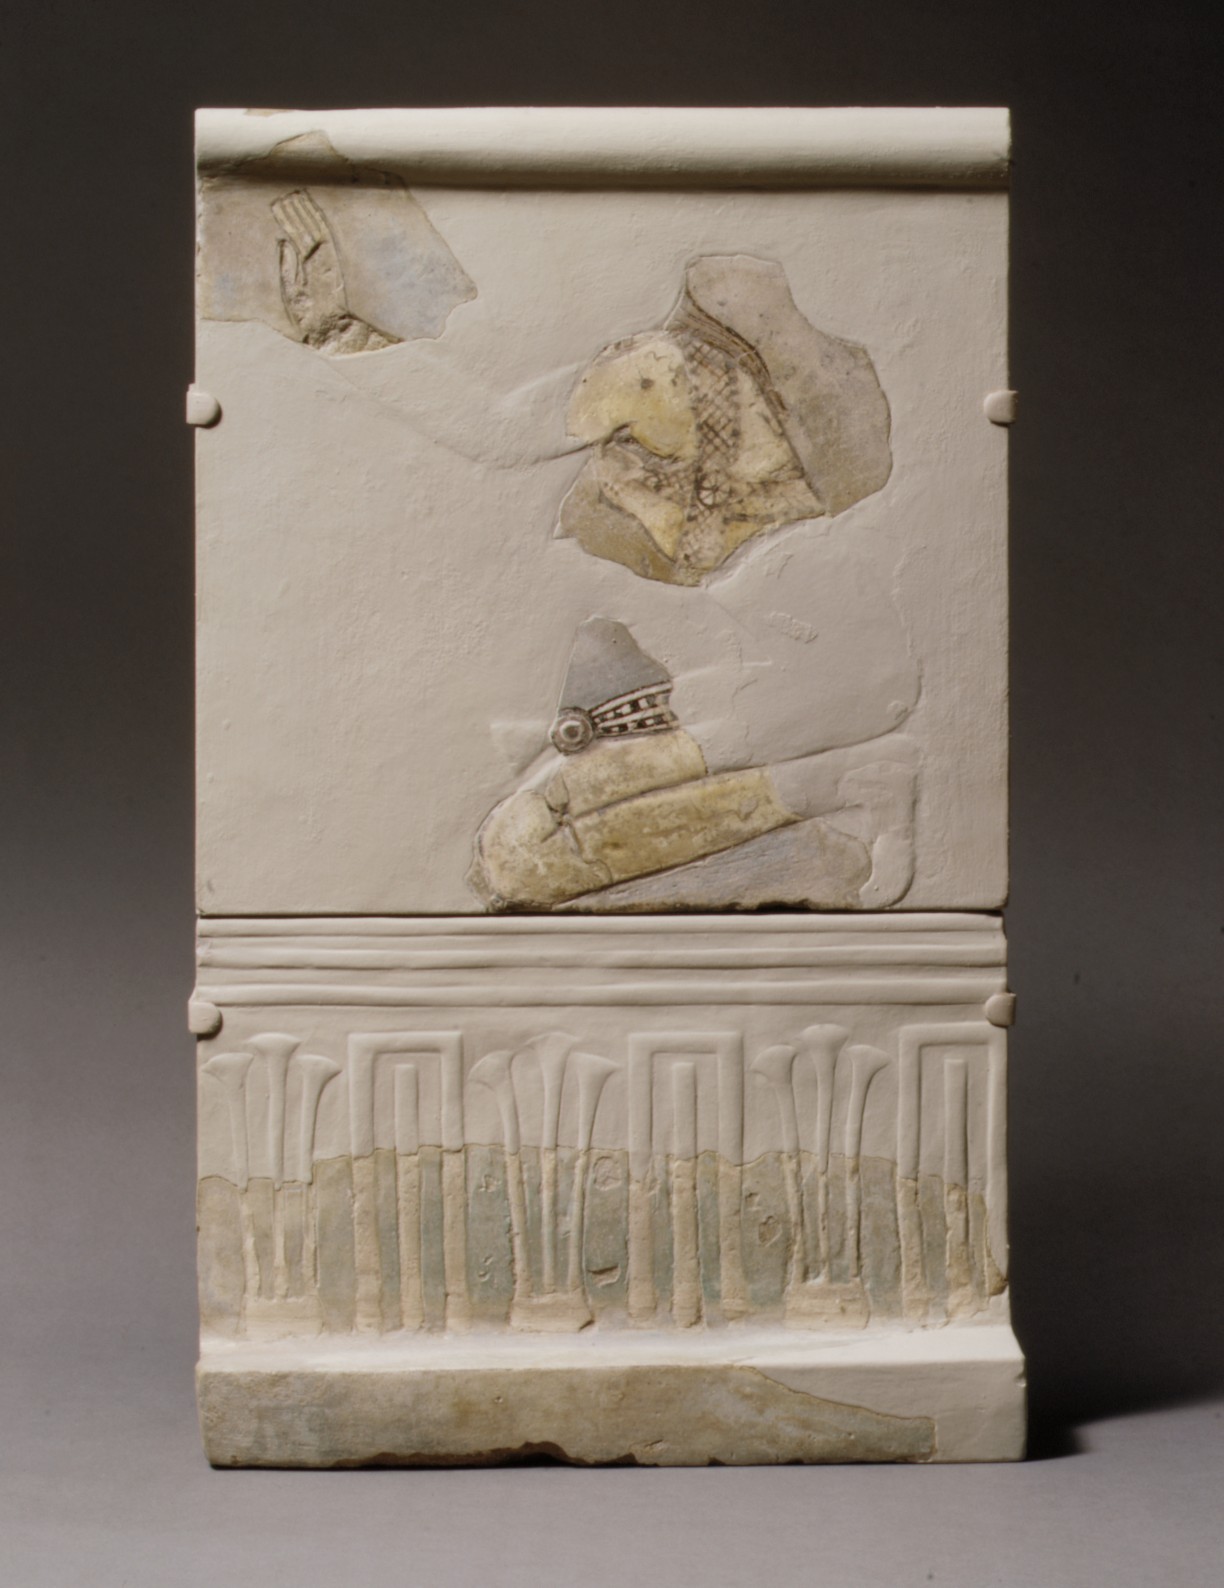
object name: relief from side of platform of dais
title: Relief from Platform of Dais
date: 1279-1213 BCE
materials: faience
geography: egypt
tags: men